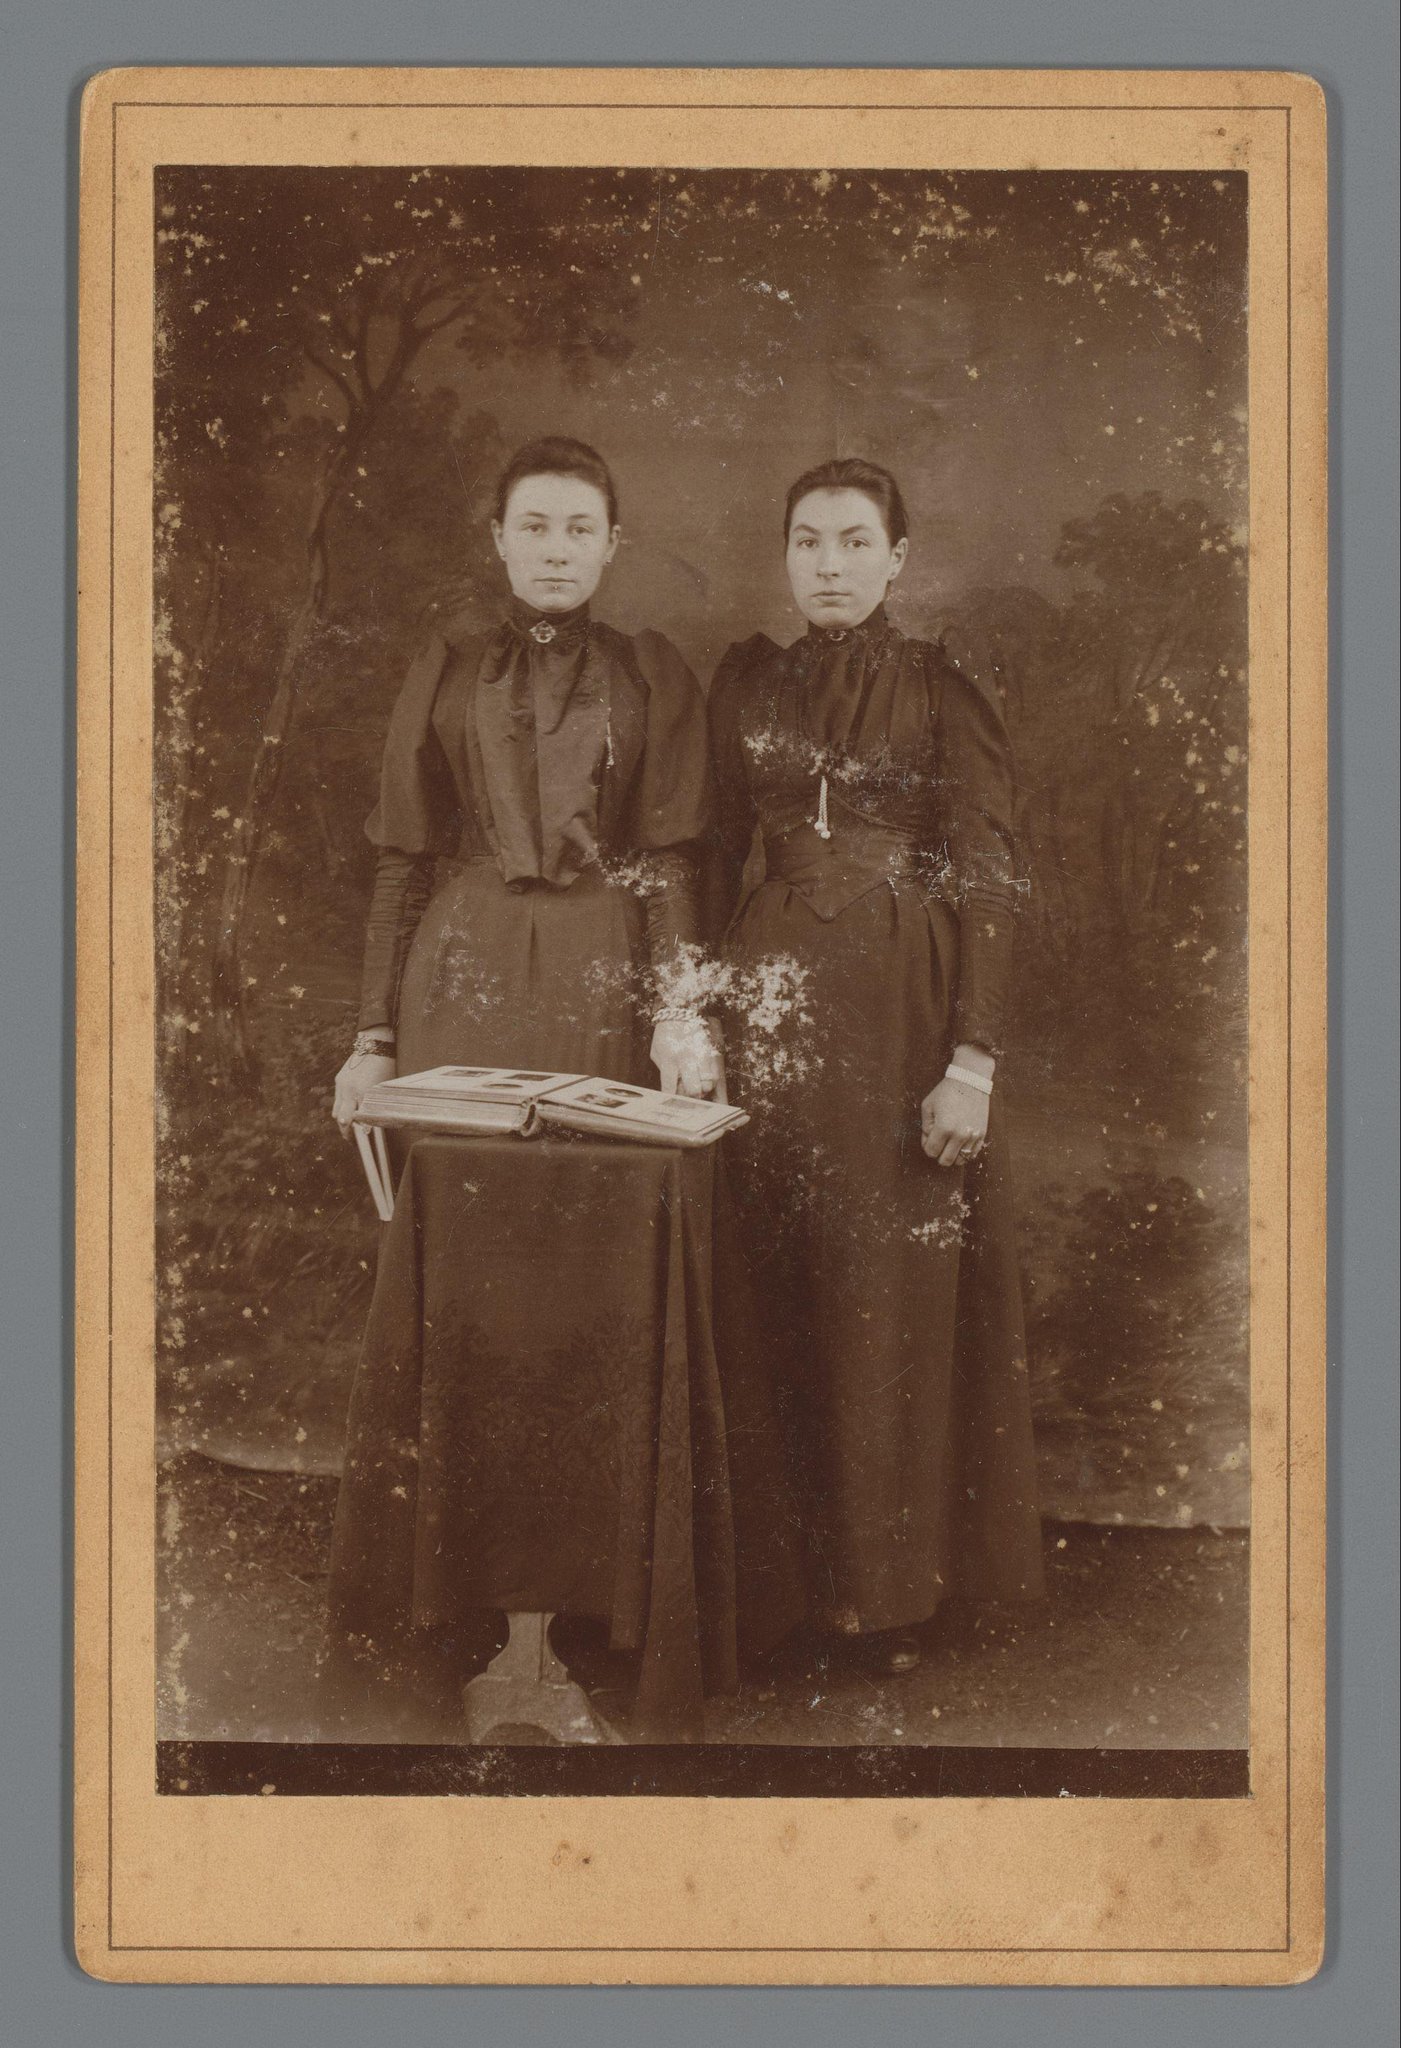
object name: cabinet photograph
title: Portret van twee onbekende vrouwen met een fotoalbum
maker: Anonymous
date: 1880-1910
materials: paper, cardboard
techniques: collodion silver print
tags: adult woman, book, anonymous historical person portrayed